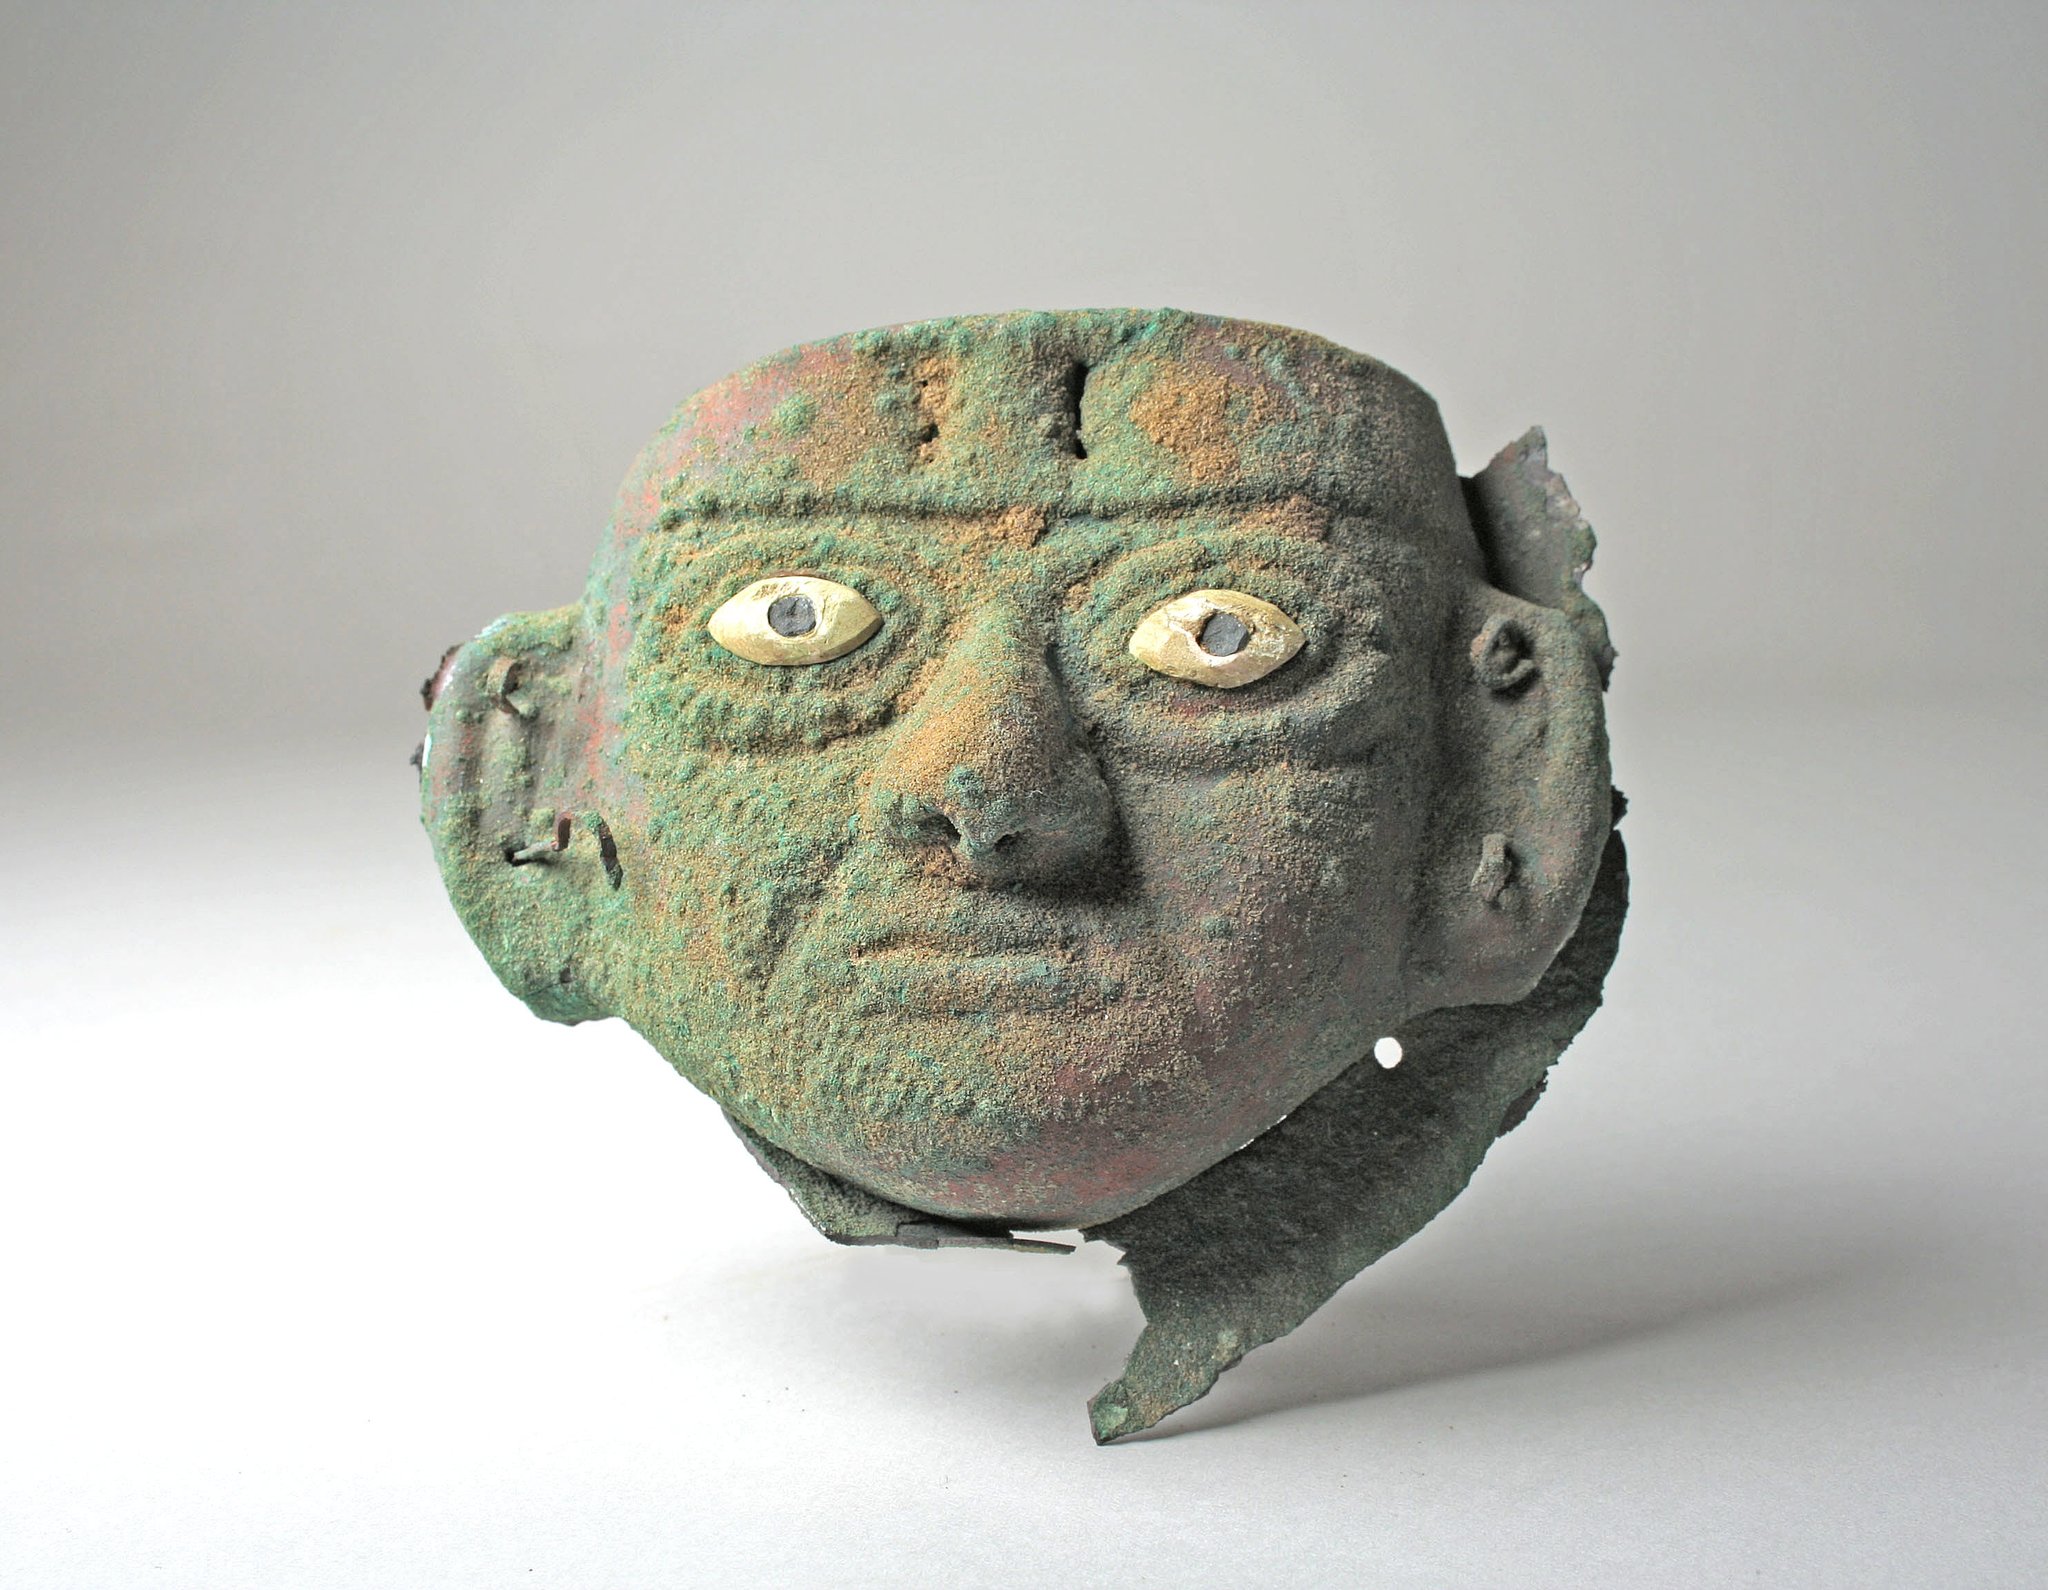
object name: ornament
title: Face Mask Ornament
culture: moche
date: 501-700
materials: gilt copper, shell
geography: peru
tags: masks